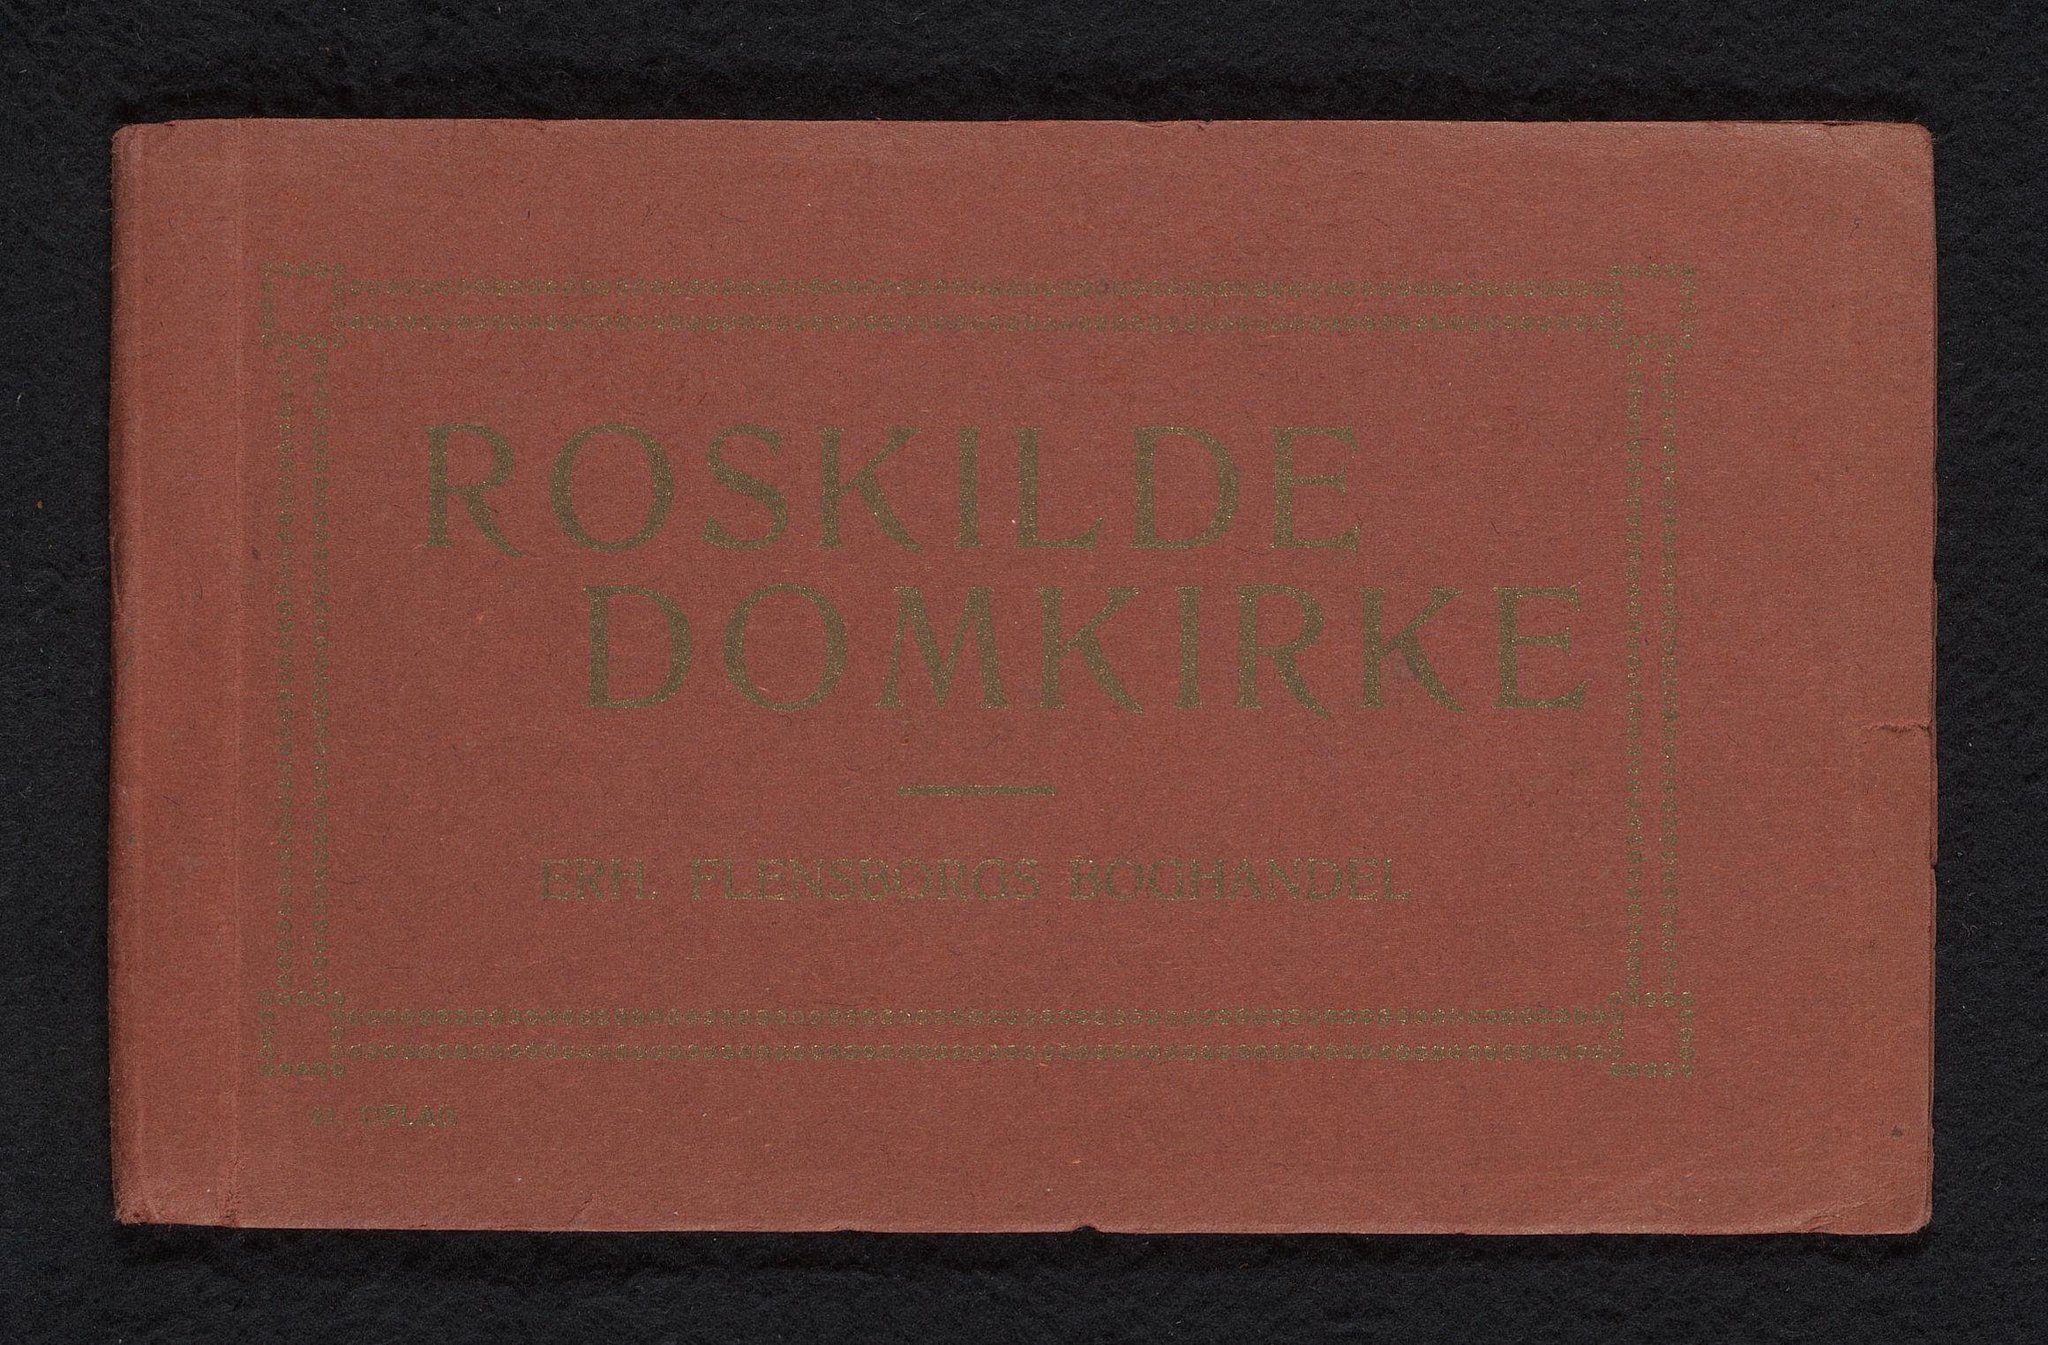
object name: album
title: Roskilde Domkirke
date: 1906-1920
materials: cardboard, paper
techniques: photograph, letterpress printing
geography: roskilde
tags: church (exterior), interior of church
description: Album met tien prentbriefkaarten van de kathedraal van Roskilde. De prentbriefkaarten kunnen eruit gescheurd worden.